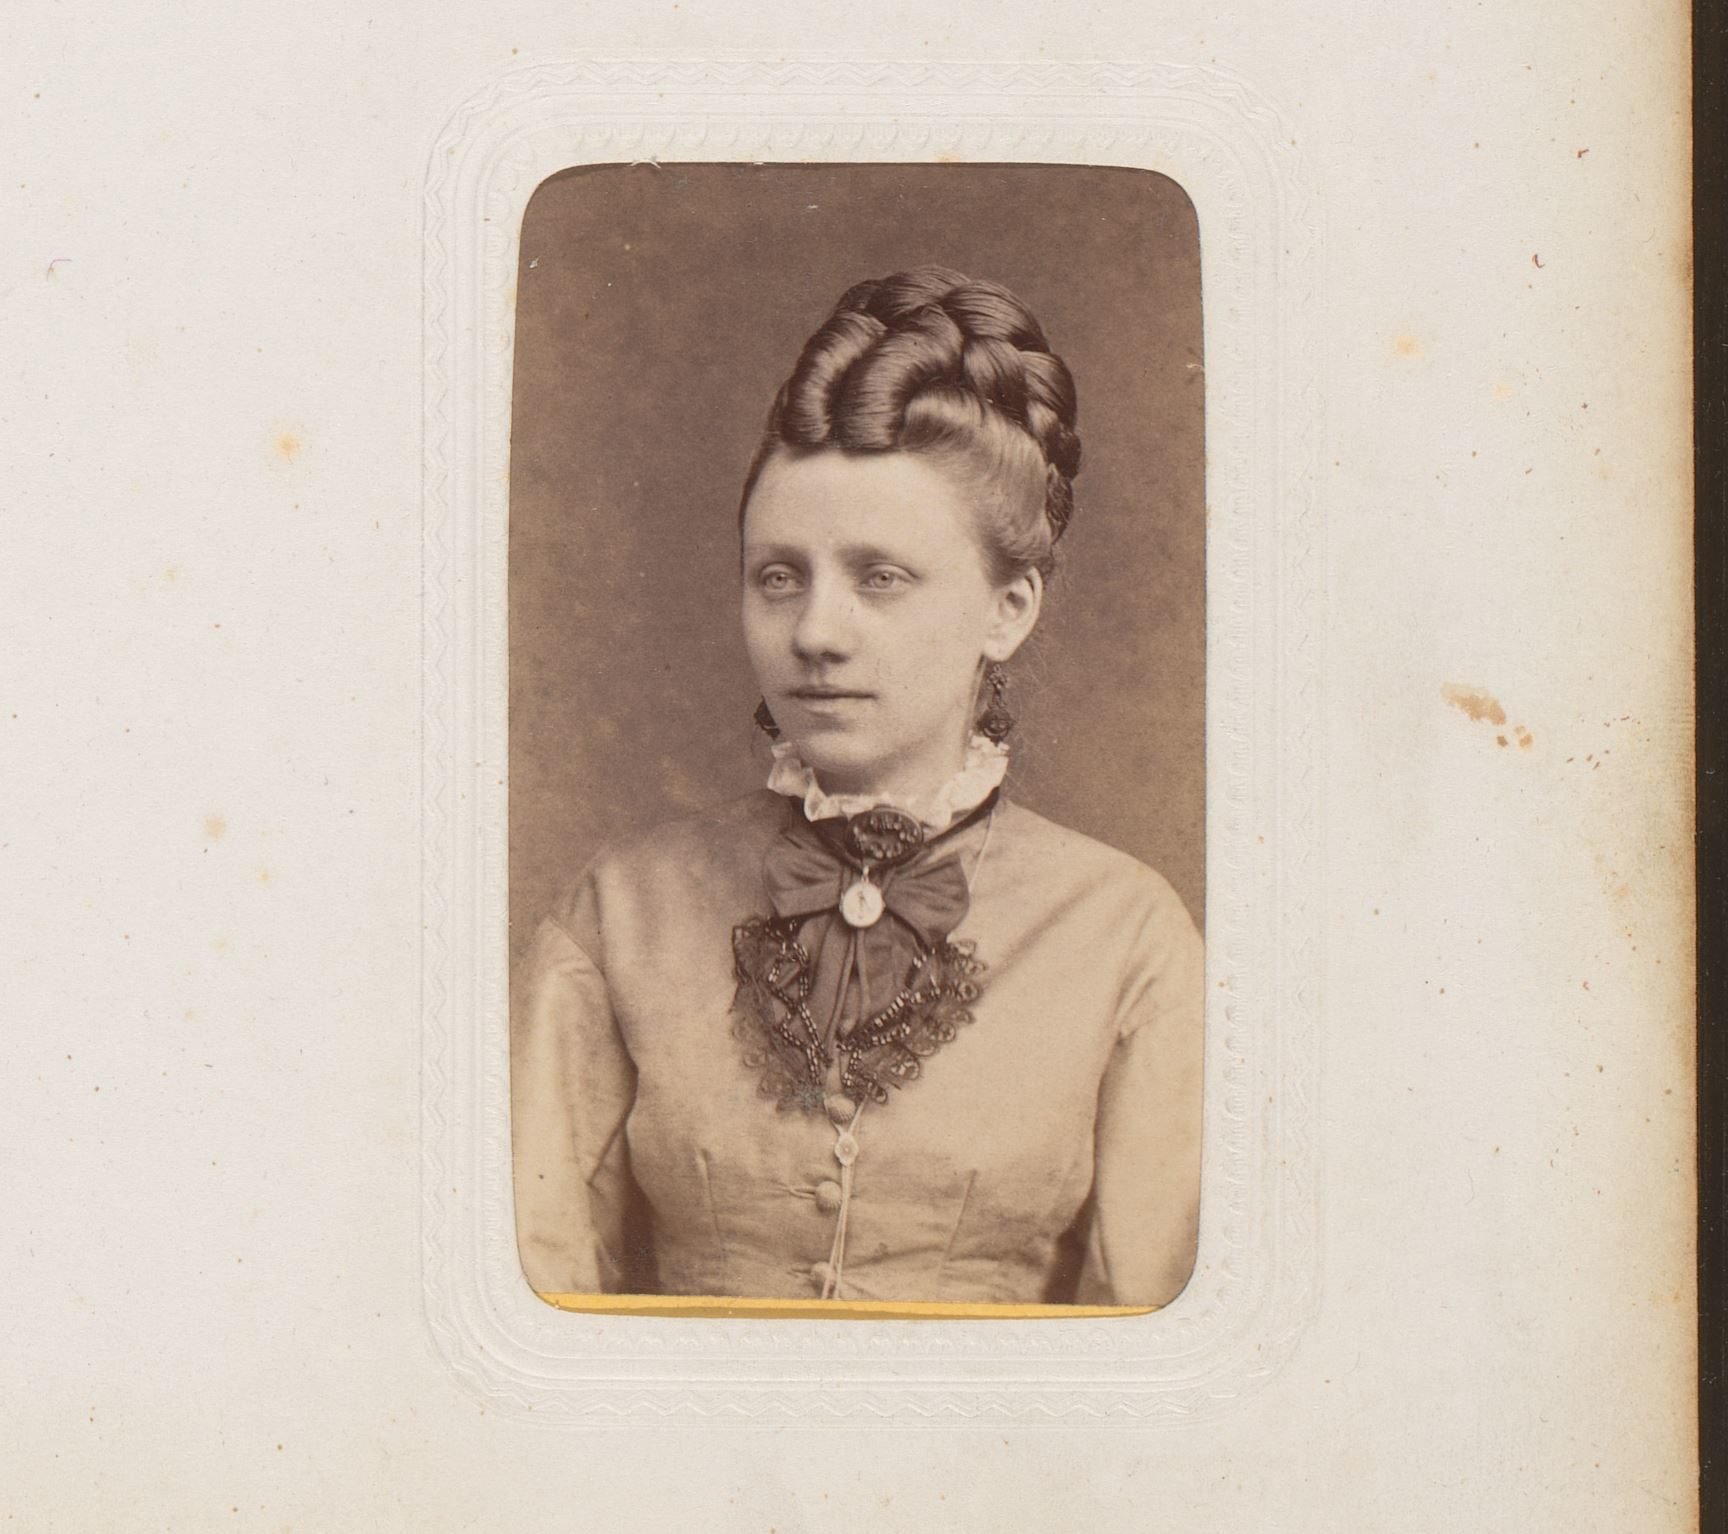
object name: carte de visite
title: Portret van een vrouw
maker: louis koch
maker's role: fotograaf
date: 1850-1900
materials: cardboard, photographic support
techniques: albumen print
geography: bremen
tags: historical persons - bb - woman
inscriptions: inscription: ‘Aus dem/ photogr./ Atelier/ von/ Louis Koch/ Bremen/ auf der Brake No. 20/ in de Nähe des Heerdenthores/ und des Bahnhofes.’